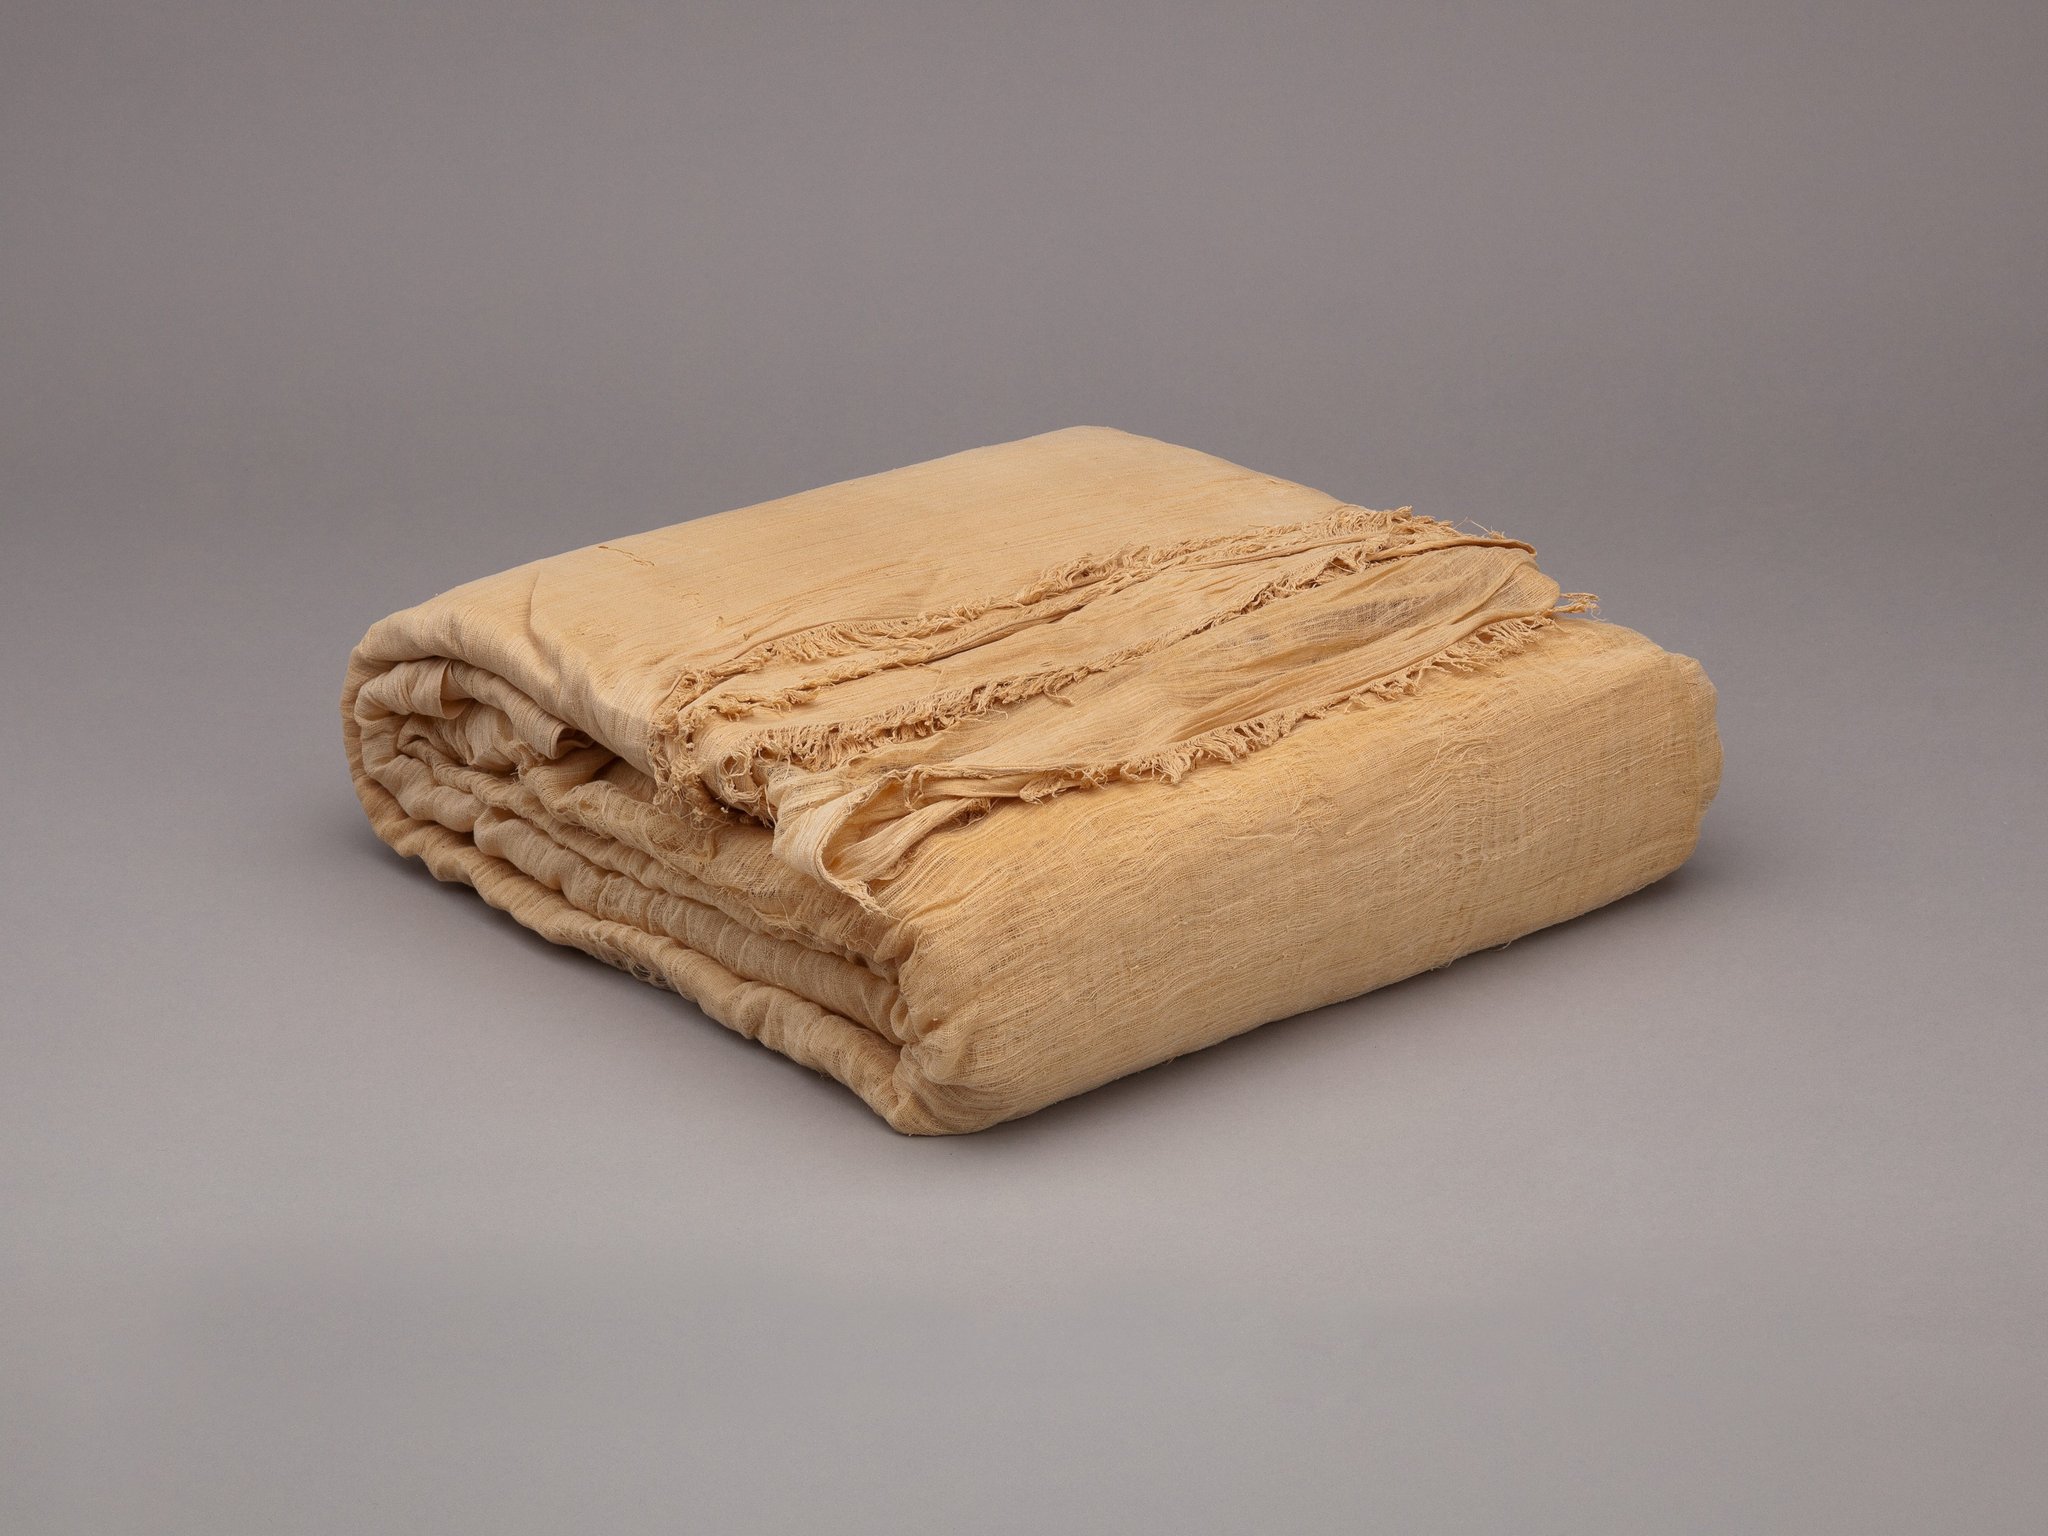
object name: sheet, inscribed, linen mark, medium spin, irregular weave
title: Sheet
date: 1492-1473 BCE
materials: ink, linen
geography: egypt